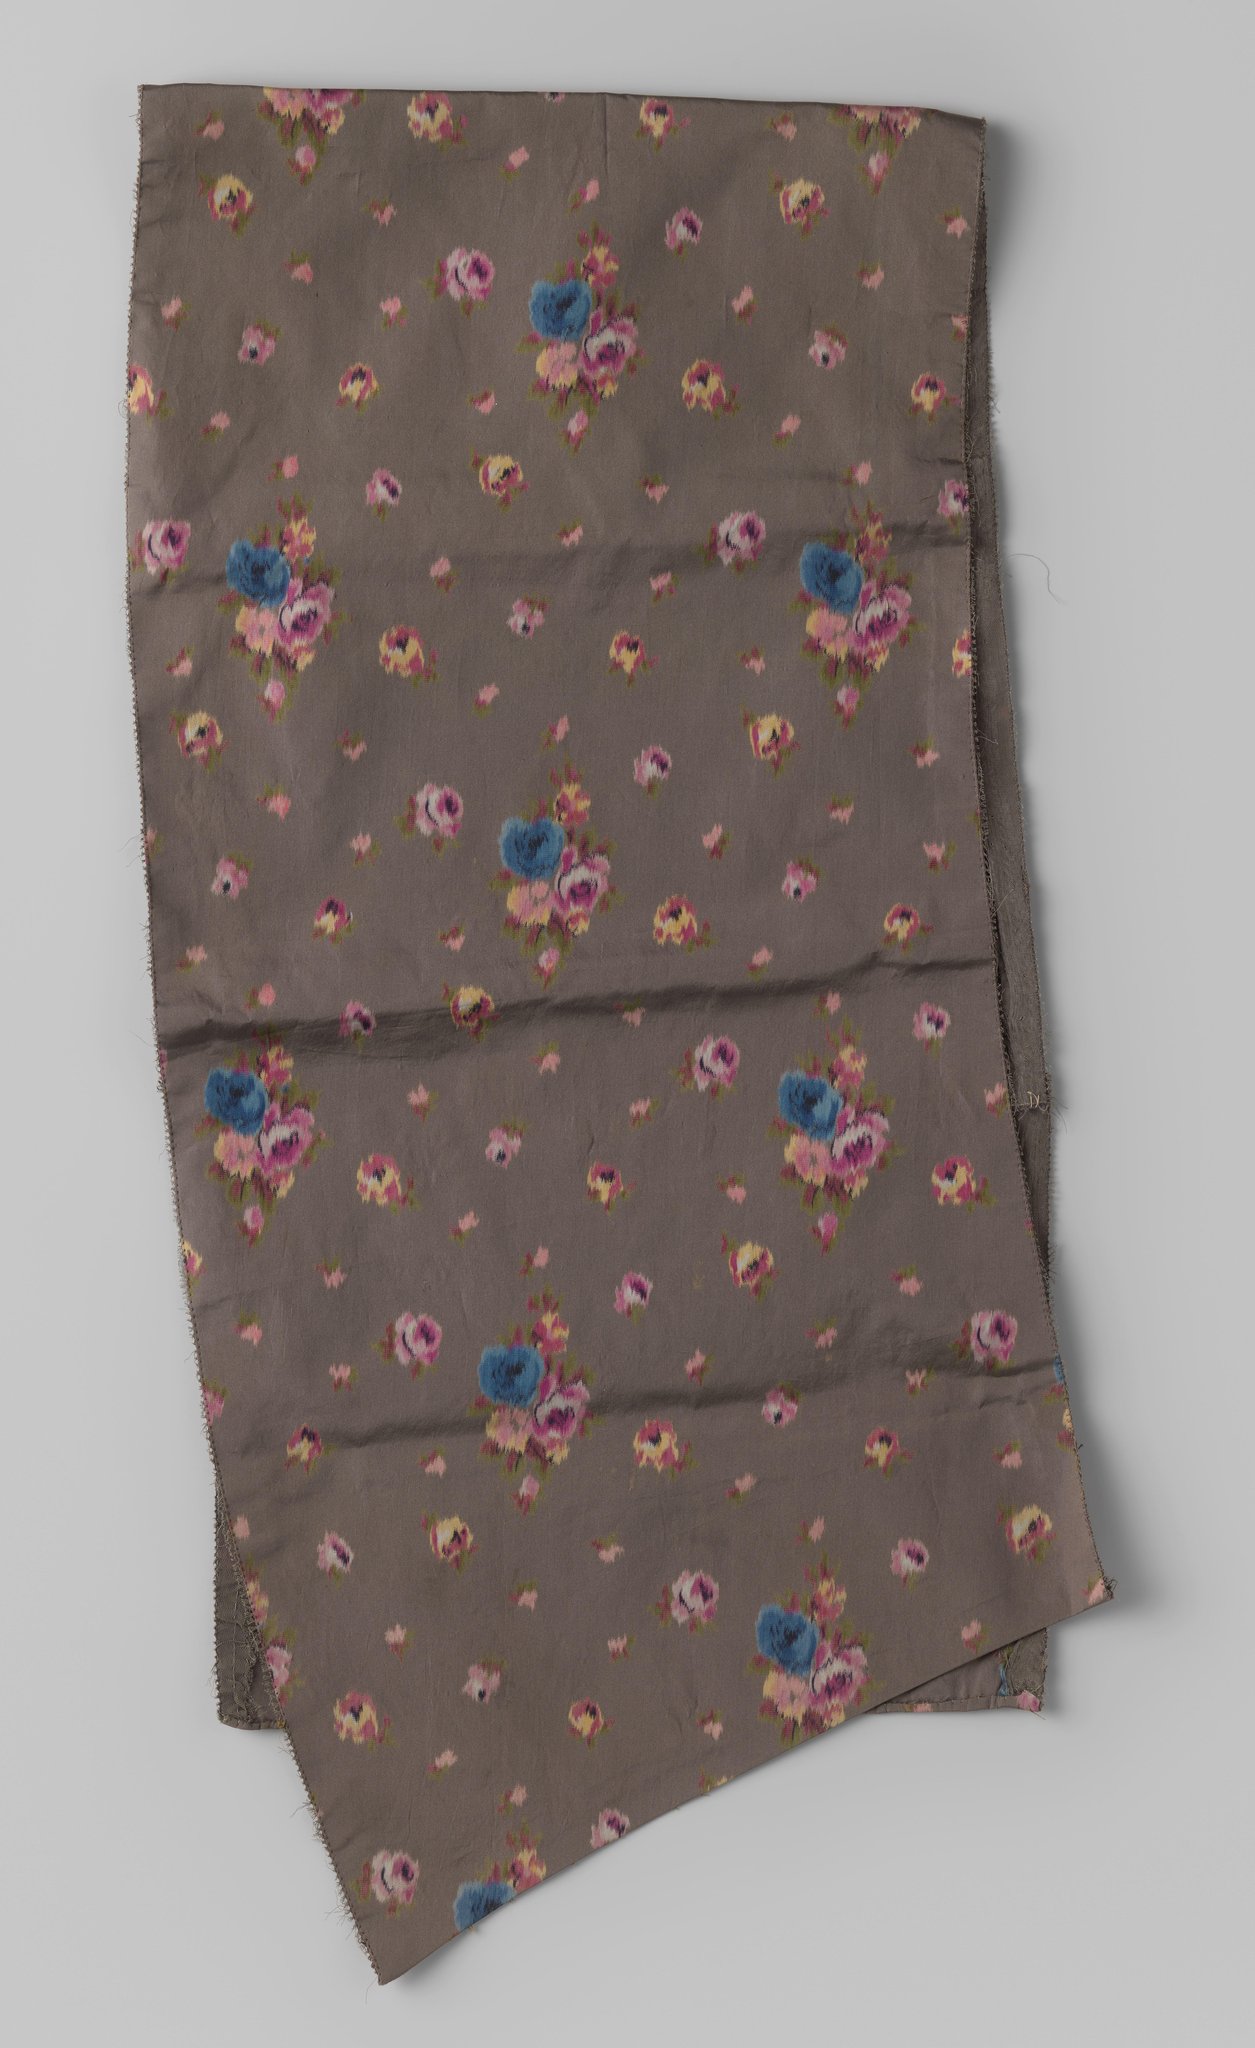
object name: sample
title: Staal van grijze chiné-zijde met motief van gestrooide rozen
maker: Anonymous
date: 1920-1930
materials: silk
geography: france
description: Staal van grijze chiné-zijde met motief van gestrooide rozen.